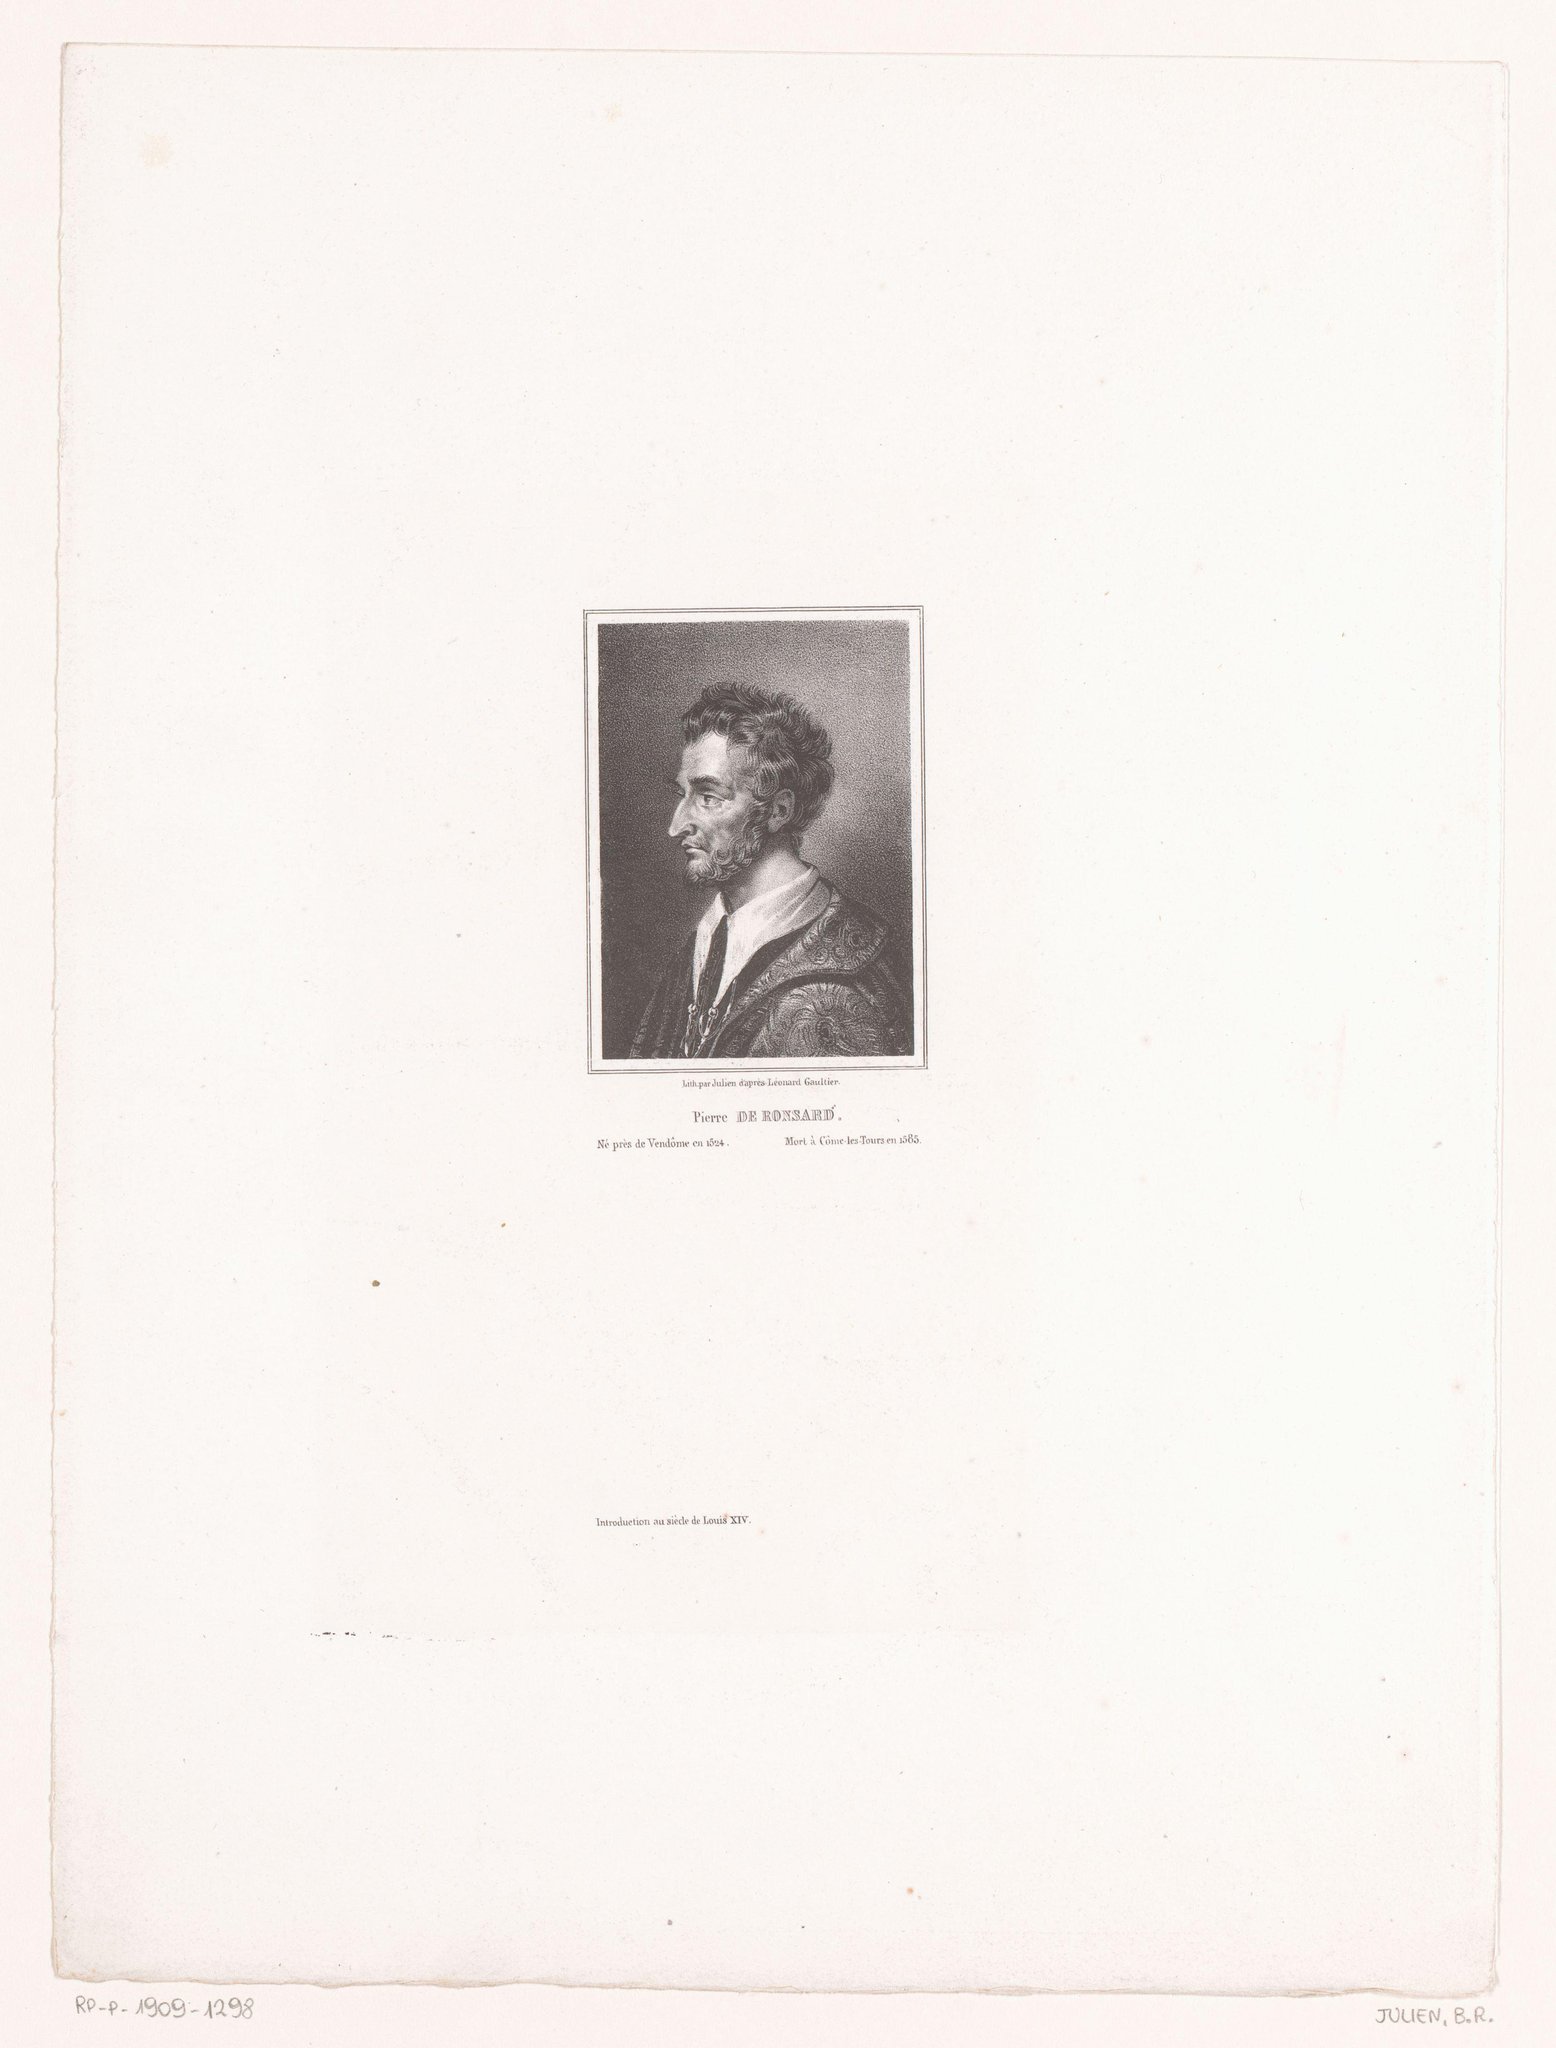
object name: print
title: Portret van Pierre de Ronsard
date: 1830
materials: paper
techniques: lithograph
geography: paris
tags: historical persons, portrait of a writer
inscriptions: collector's mark: Lugt 2228a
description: Prent gebruikt voor: Illustrations du Cours de Littérature de la Harpe, ou collection de 400 portraits destinés à l'ornement de cet ouvrage. Parijs: Boblet, 1830.